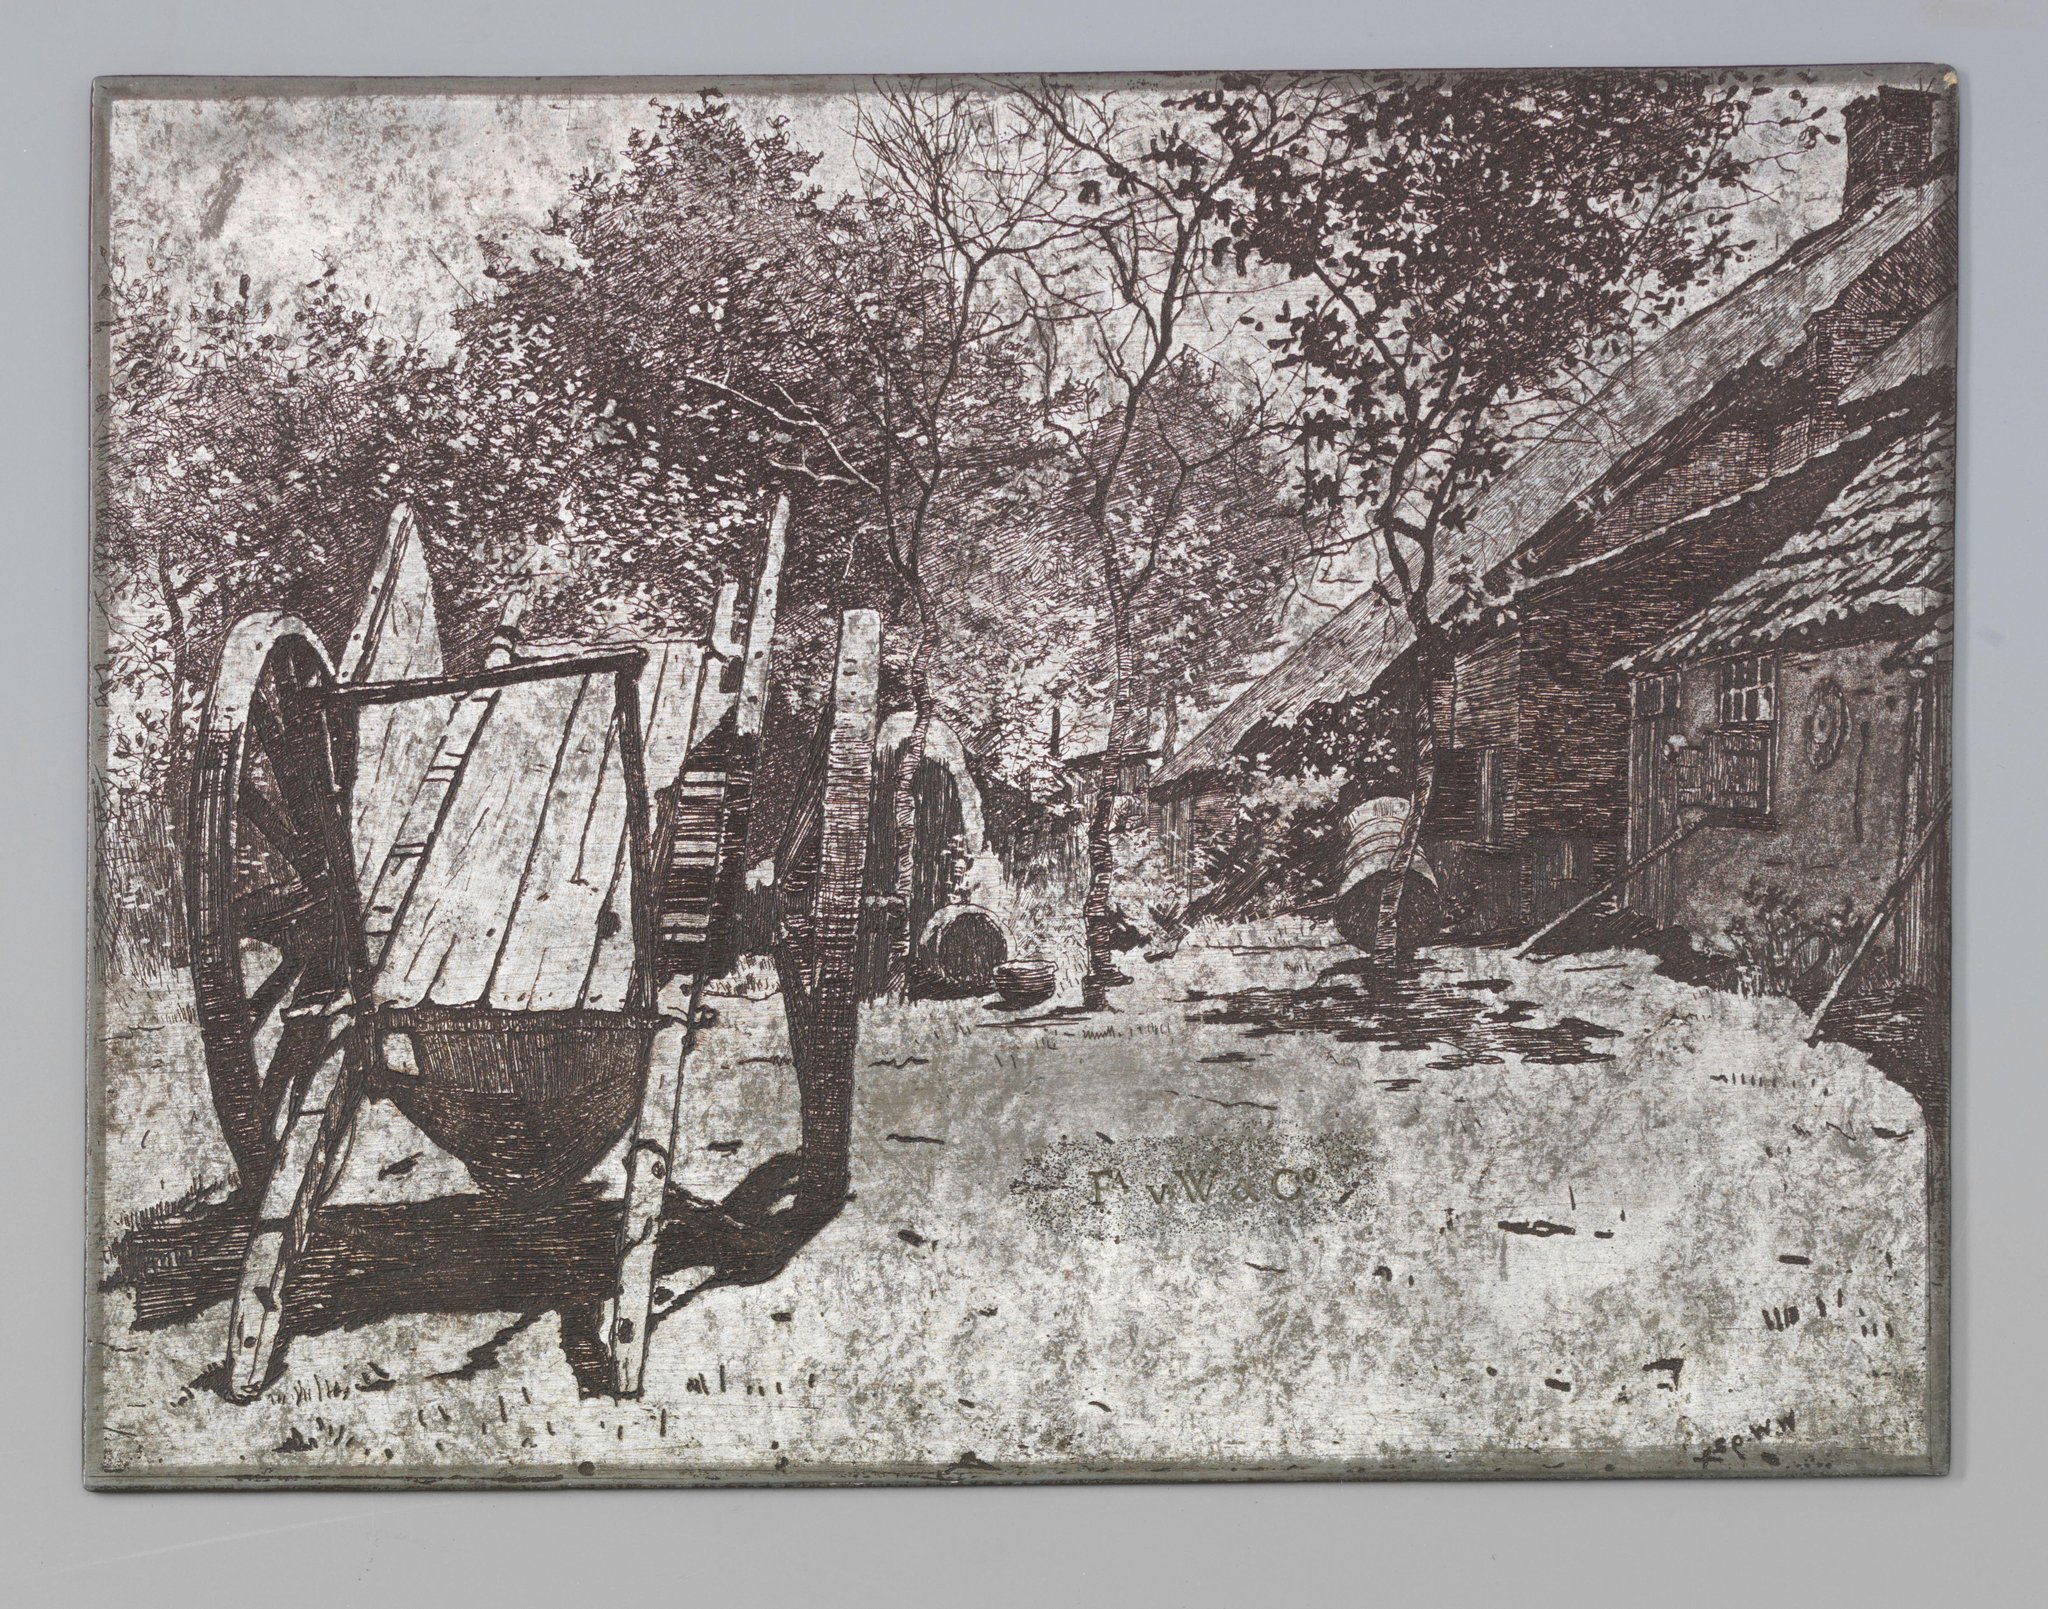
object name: zinkplaat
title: Wagen op boerenerf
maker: willem witsen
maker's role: draughtsman, painter, print maker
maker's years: 1860-1923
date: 1892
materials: zinc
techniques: etching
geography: north brabant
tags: noord-brabant